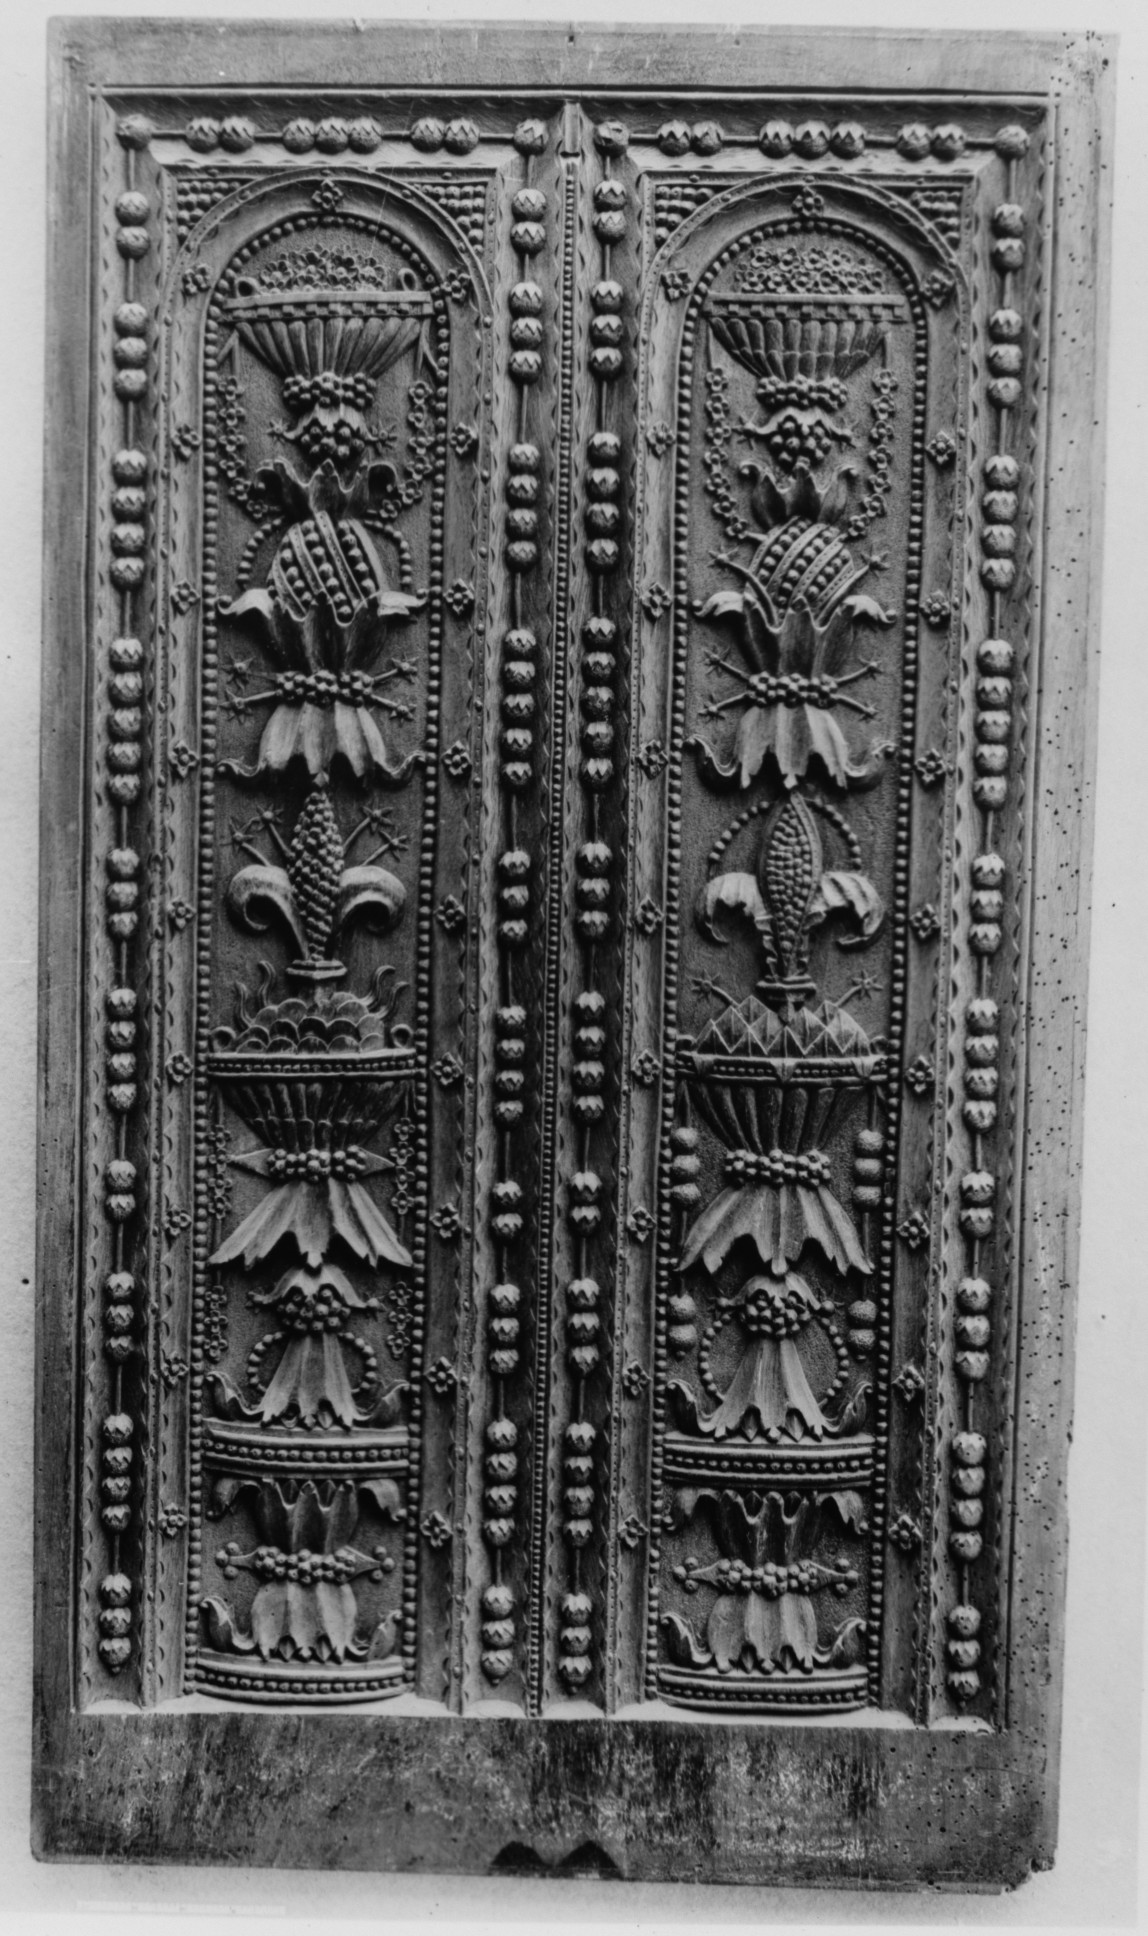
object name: panel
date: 1510-1515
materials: wood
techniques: carving